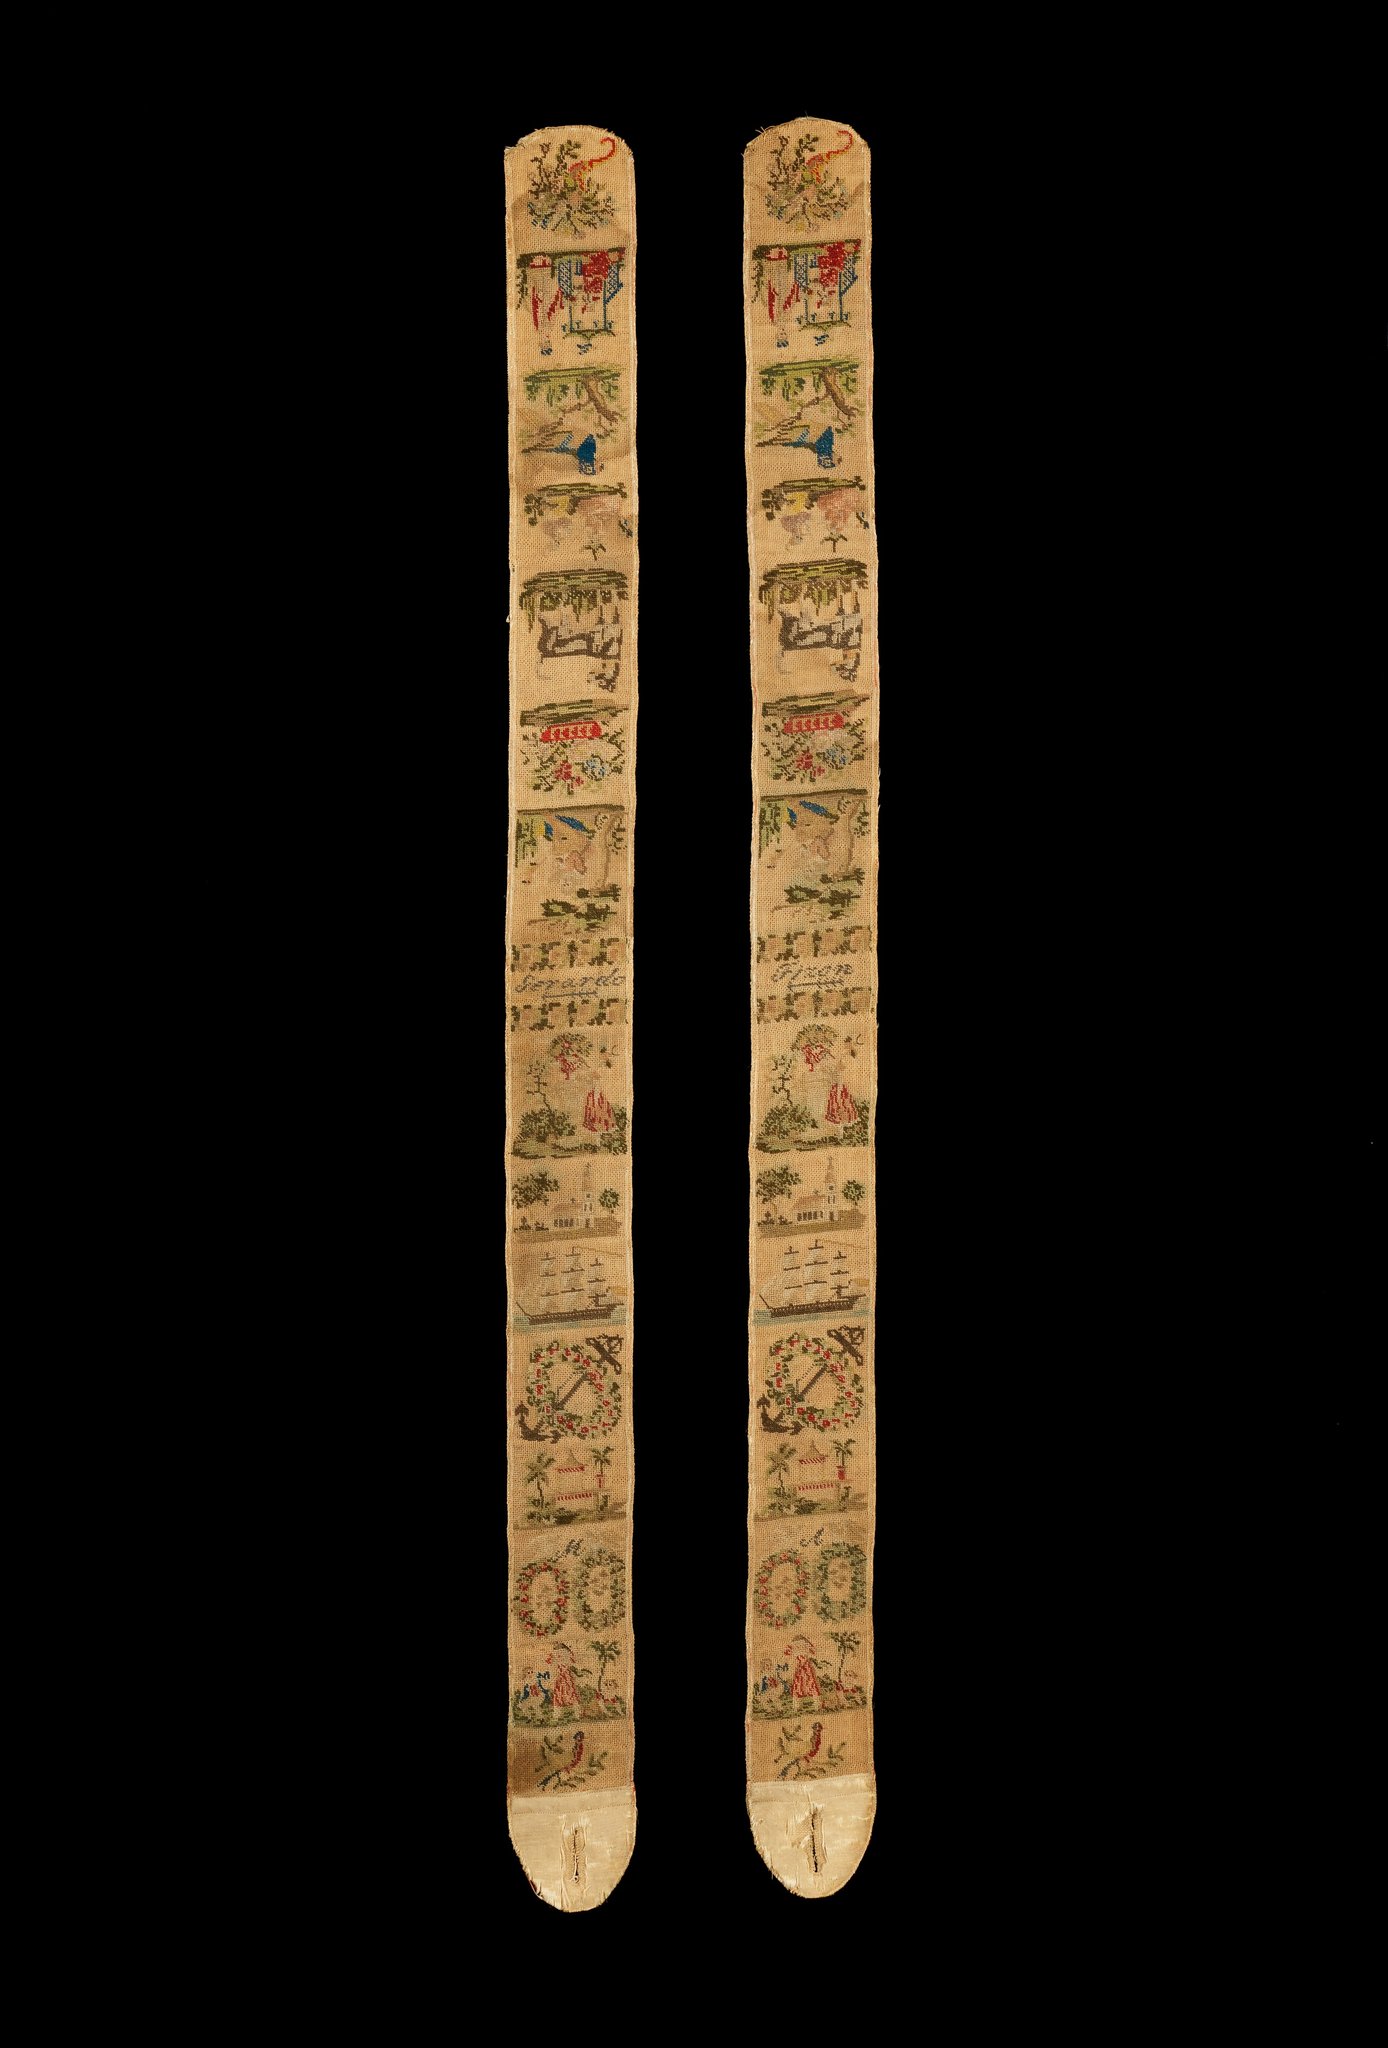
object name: suspender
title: Suspenders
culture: portuguese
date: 1840-1849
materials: linen, silk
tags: birds,dogs